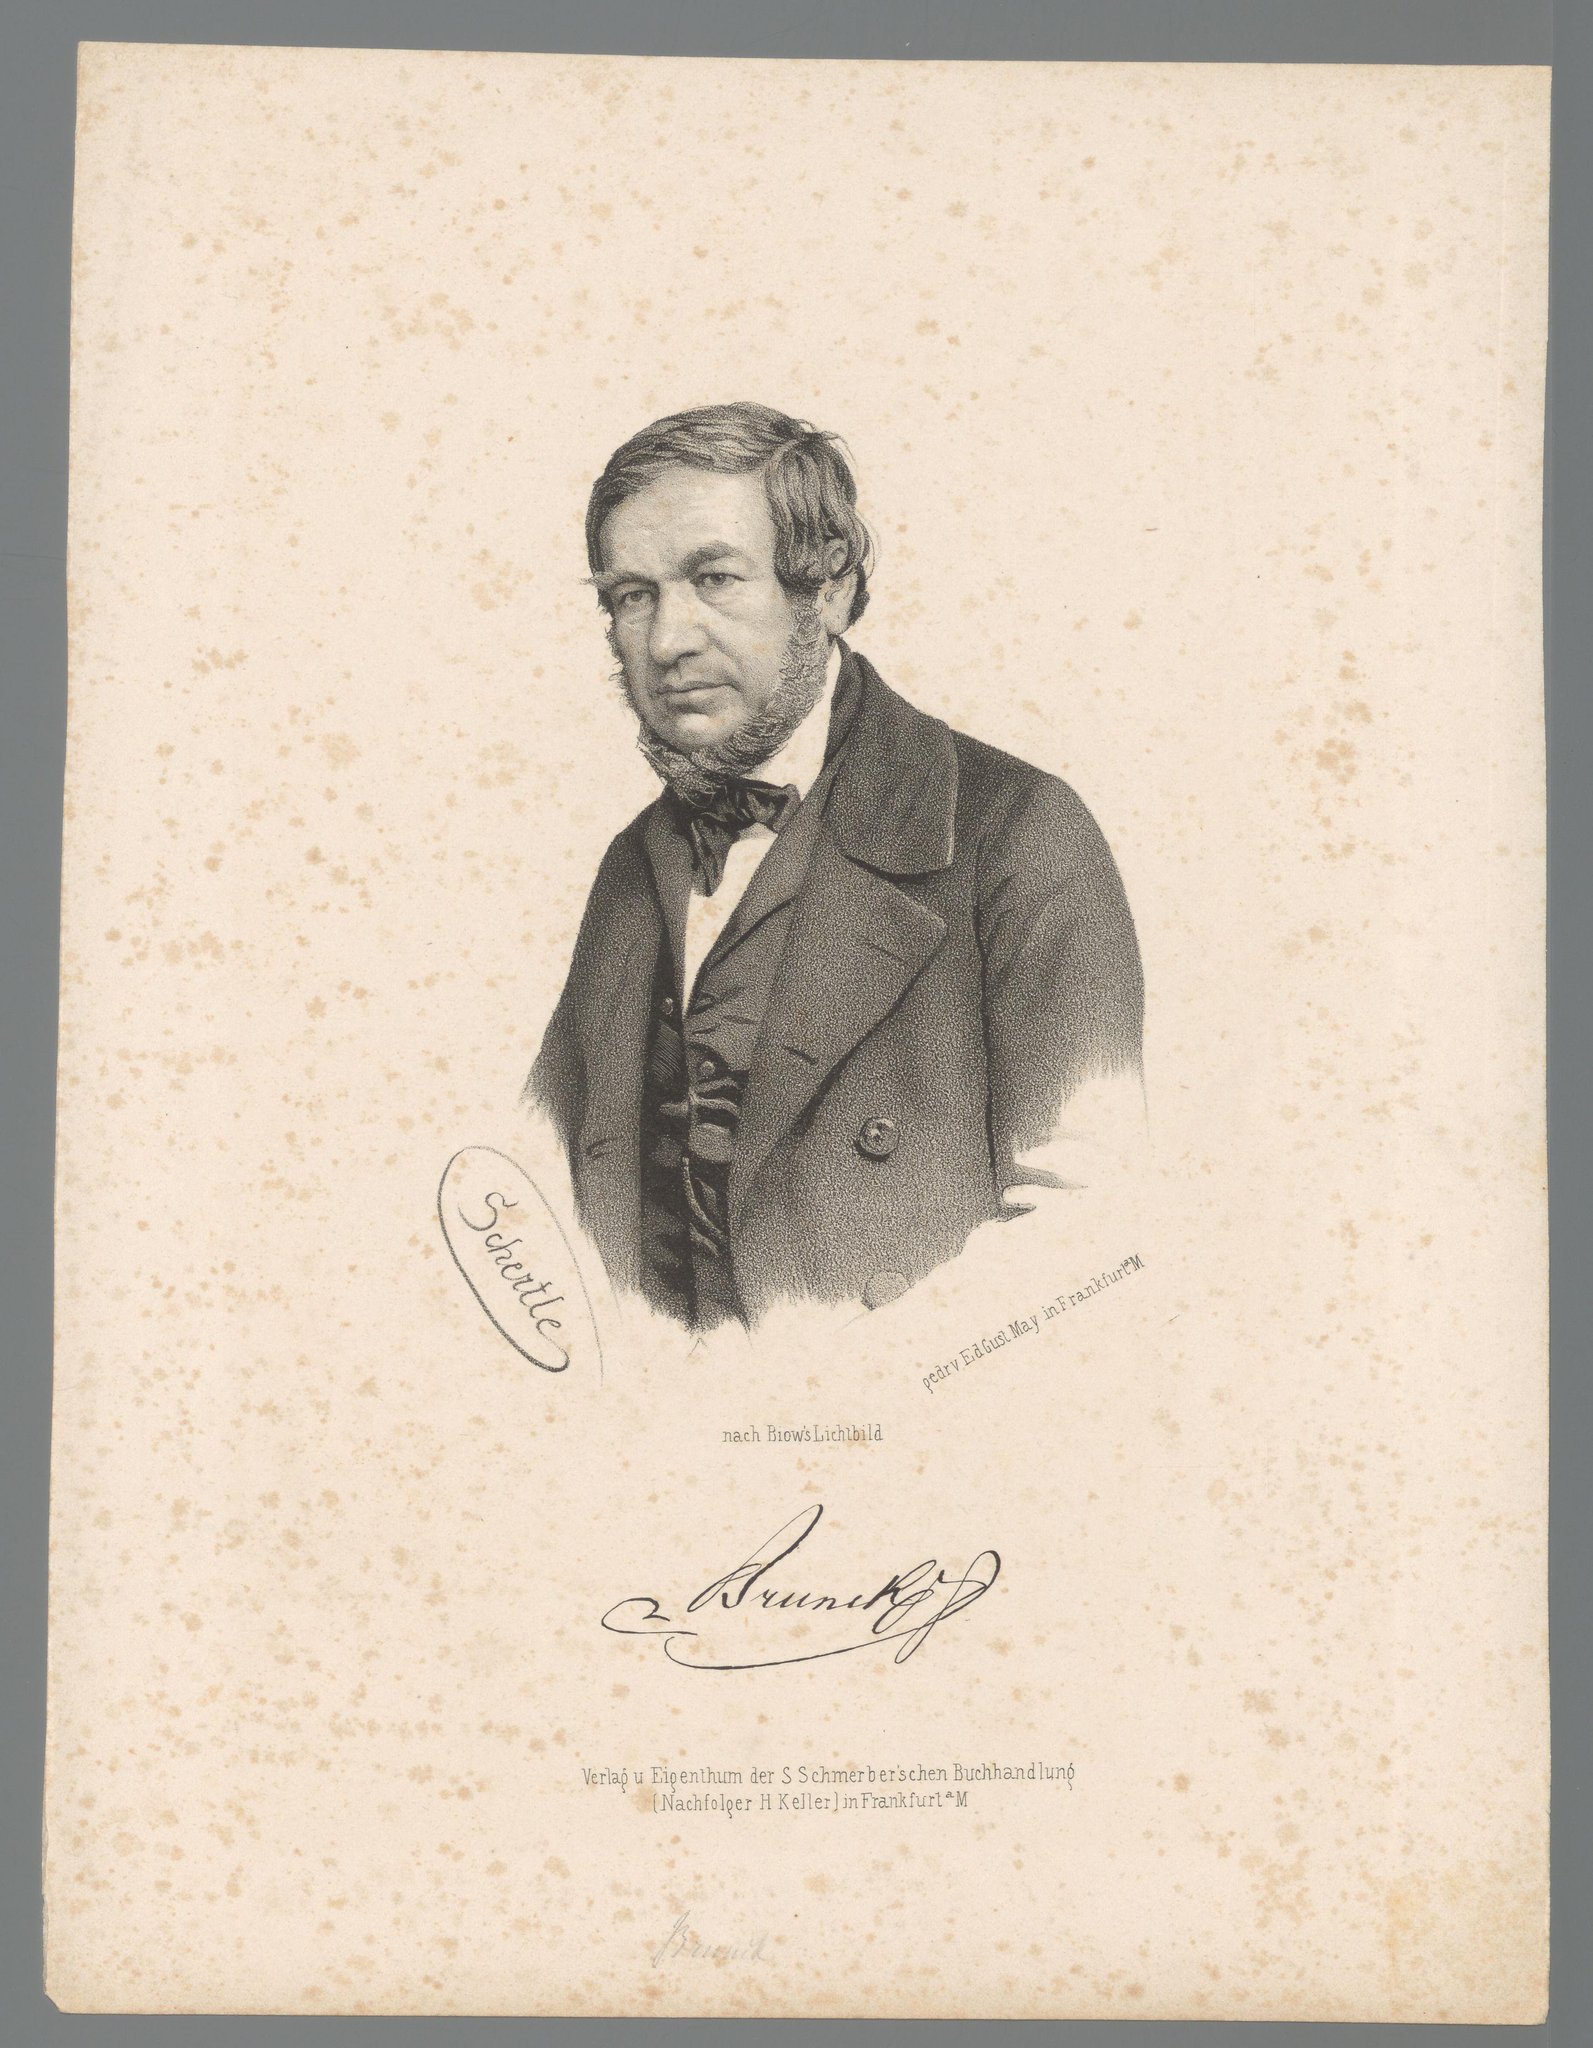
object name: print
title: Portret van Franz Joseph Brunck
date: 1848-1849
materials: paper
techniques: lithograph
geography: frankfurt am main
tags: adult man, historical persons, beard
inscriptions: collector's mark: Lugt 2228